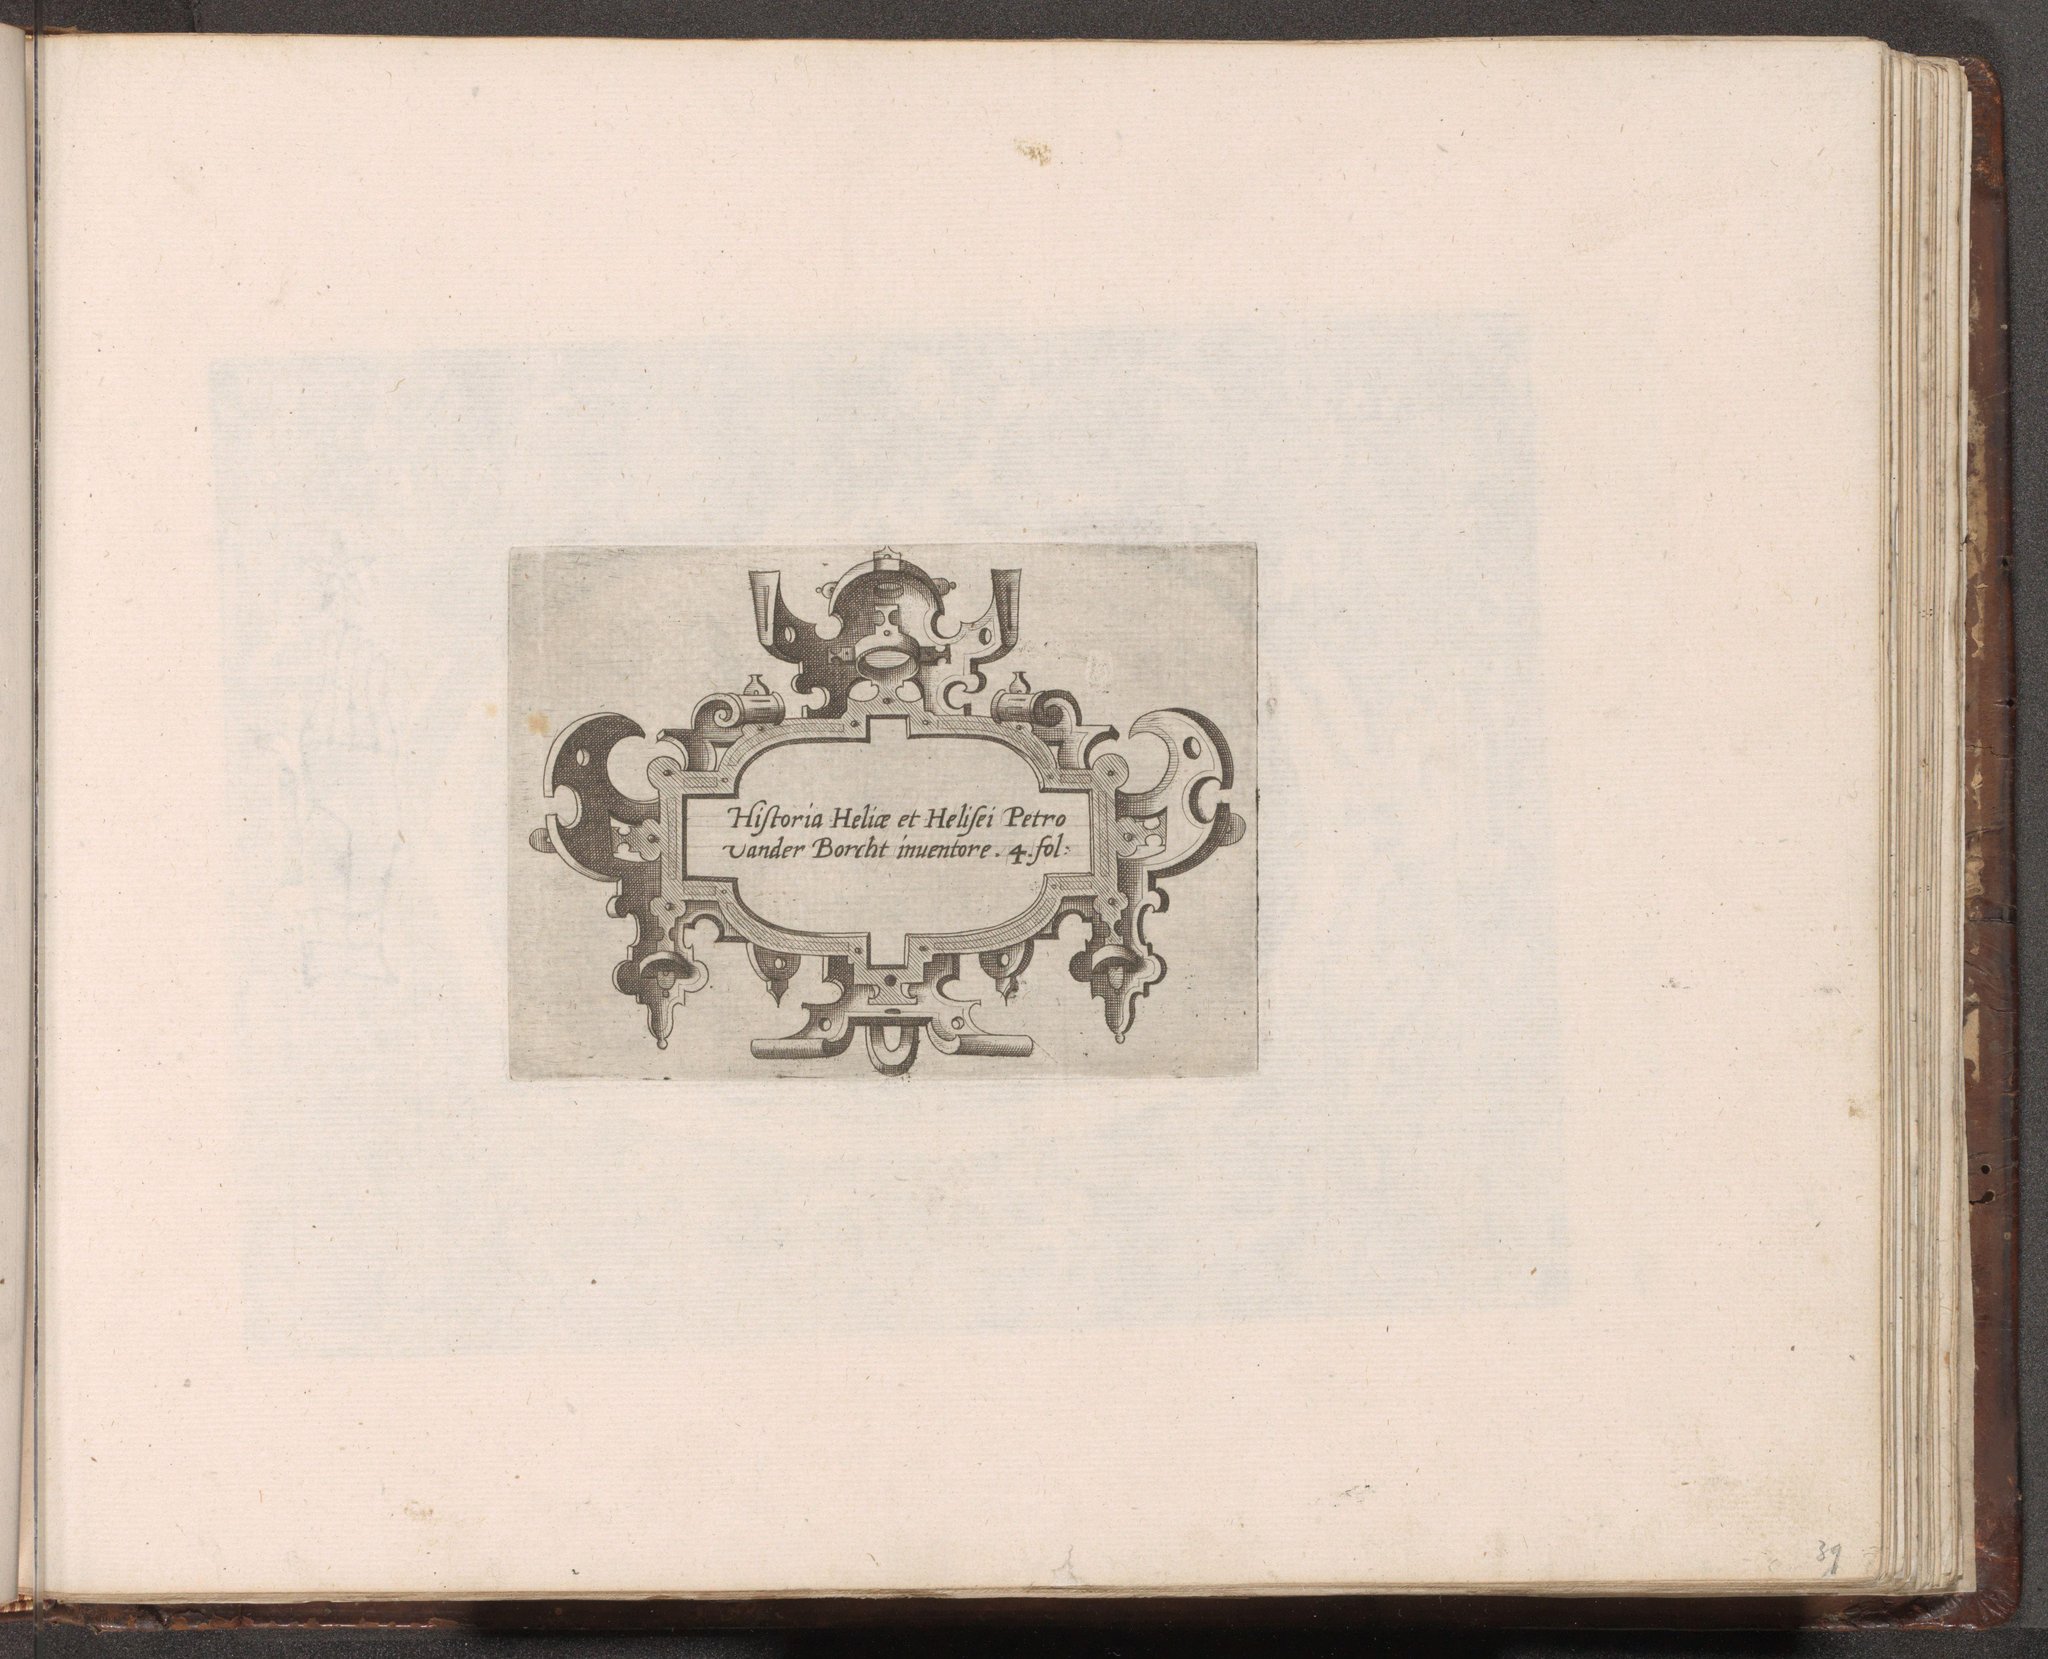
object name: titelprent, frontispice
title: Thesaurus sacrarum historiaru[m] veteris testame[n]ti, elega[n]tissimis imaginibus expressu[m] excelle[n]tissimoru[m] in hac arte viroru[m] opera: nu[n]c primu[m] in luce[m] editus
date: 1579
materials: paper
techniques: engraving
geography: antwerp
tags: scrollwork, strapwork ~ ornament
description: Titel in cartouche met rolwerk. Titelprent voor een serie prenten over de geschiedenis van de profeten Elia en Elisa. Prent maakt deel uit van een album.